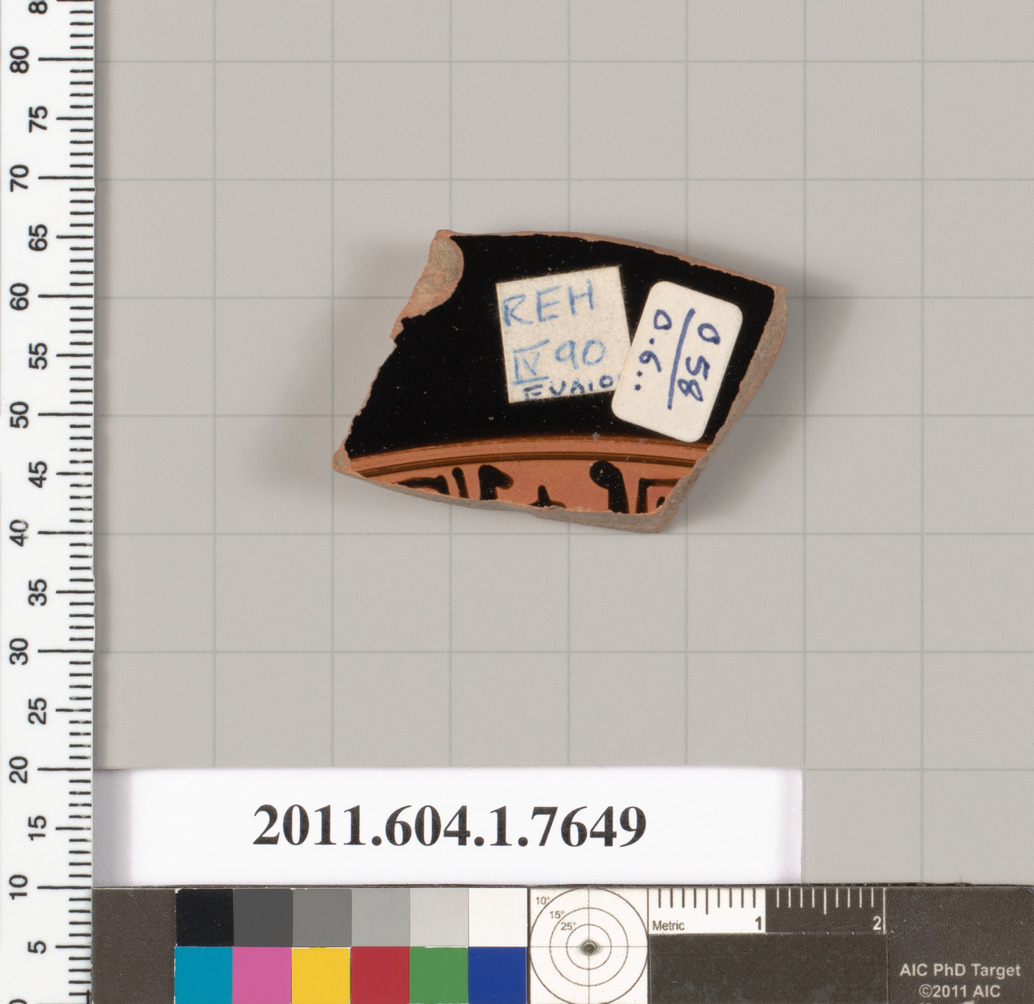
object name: kylix fragment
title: Terracotta fragment of a kylix (drinking cup)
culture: greek, attic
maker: euaion painter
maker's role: artist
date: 460-450 BCE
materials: terracotta